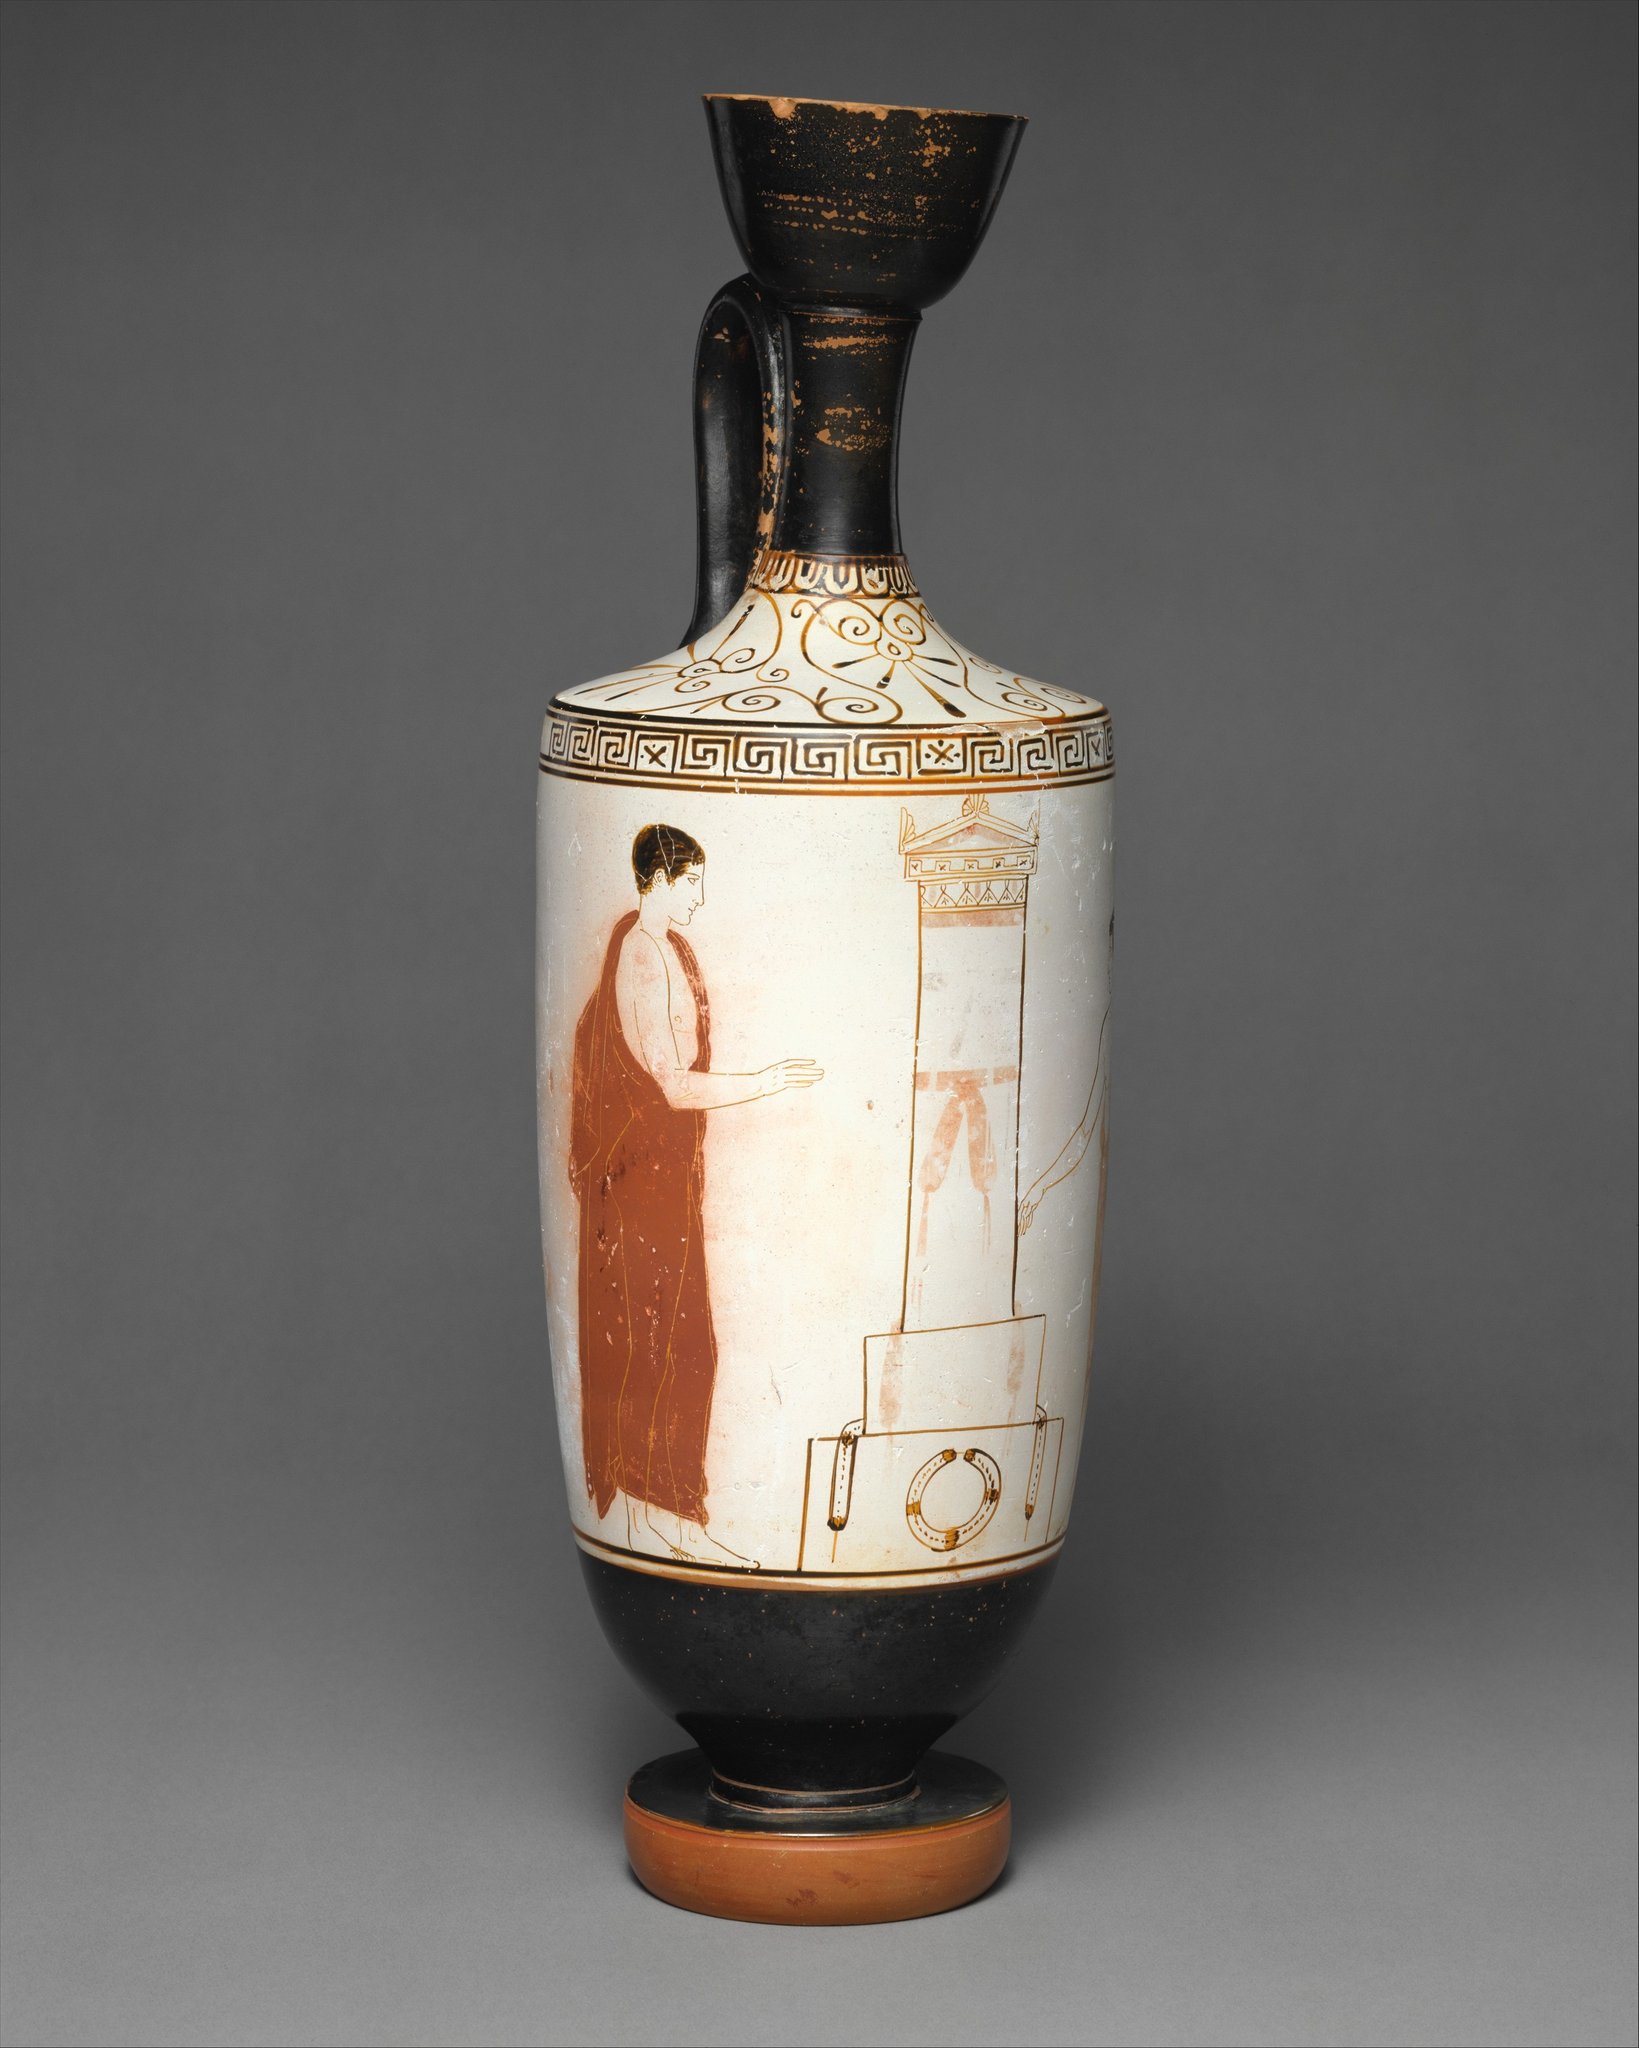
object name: lekythos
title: Terracotta lekythos (oil flask)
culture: greek, attic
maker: achilles painter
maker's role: artist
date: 440 BCE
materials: terracotta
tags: tombs,men